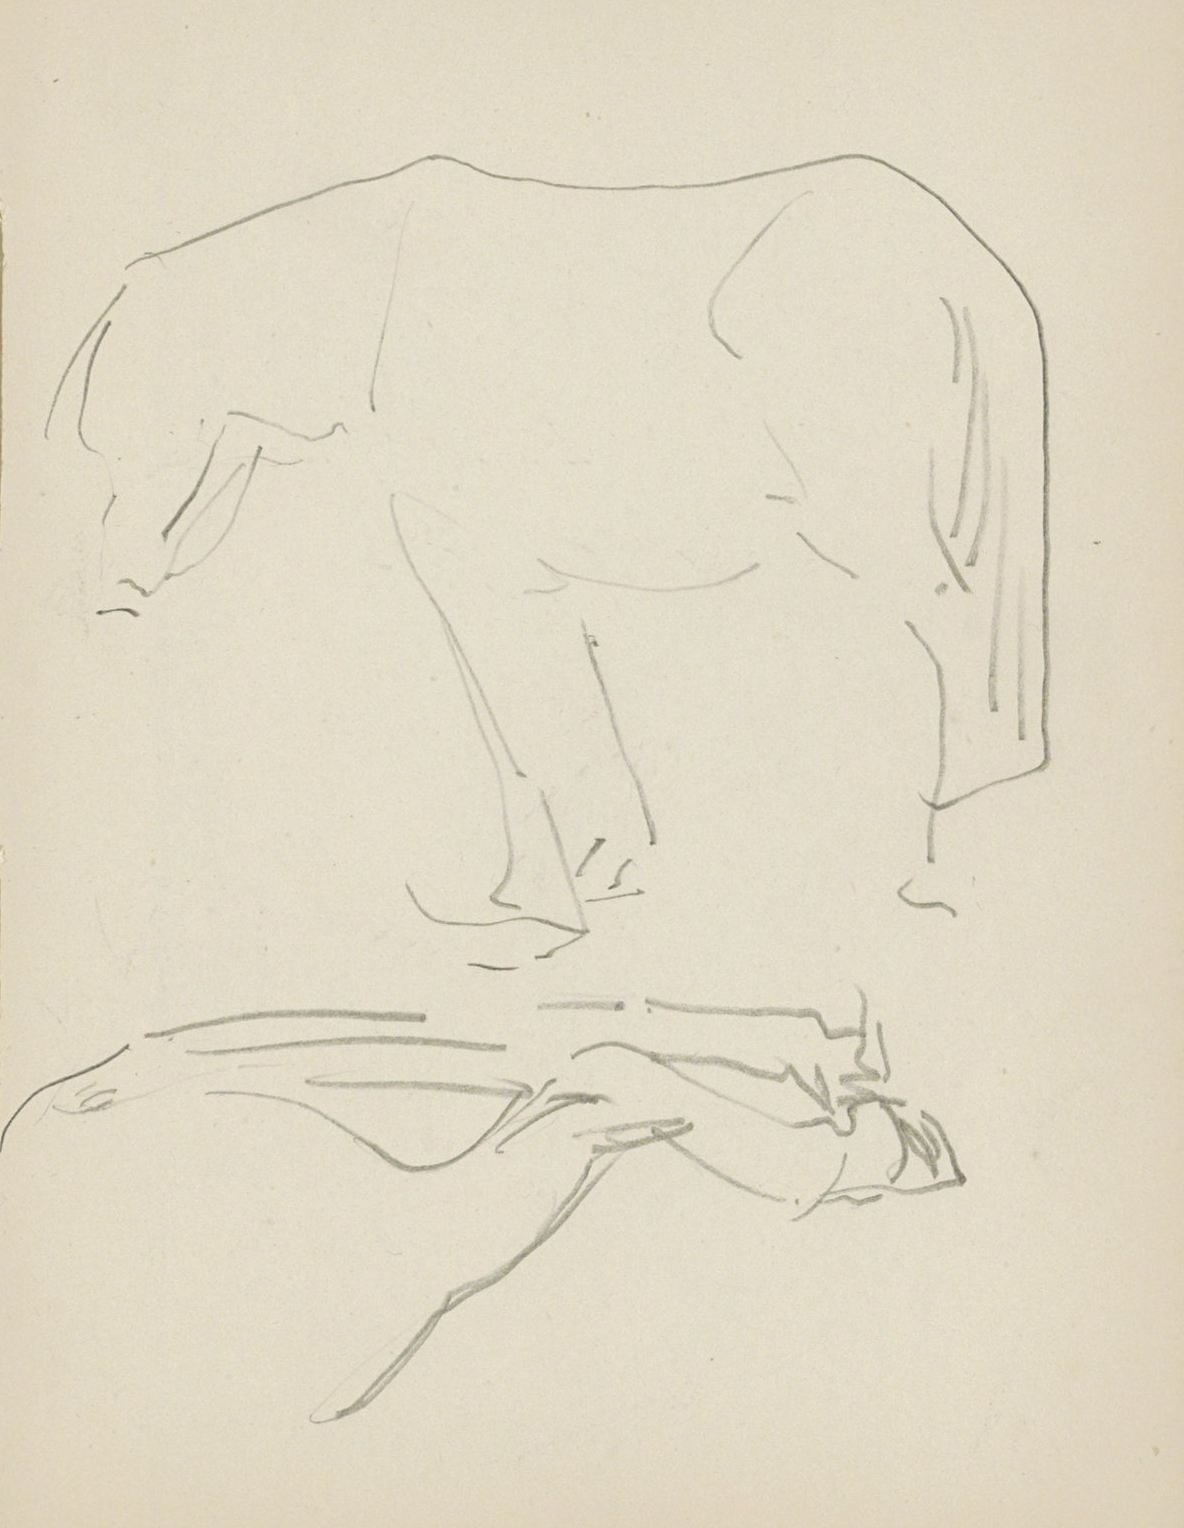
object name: sketchbook leaf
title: Paard en de achterbenen van een paard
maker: reijer stolk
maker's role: draughtsman, print maker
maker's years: 1896-1945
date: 1906-1945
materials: paper, pencil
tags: horse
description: Blad 23 recto uit een schetsboek met 69 bladen.